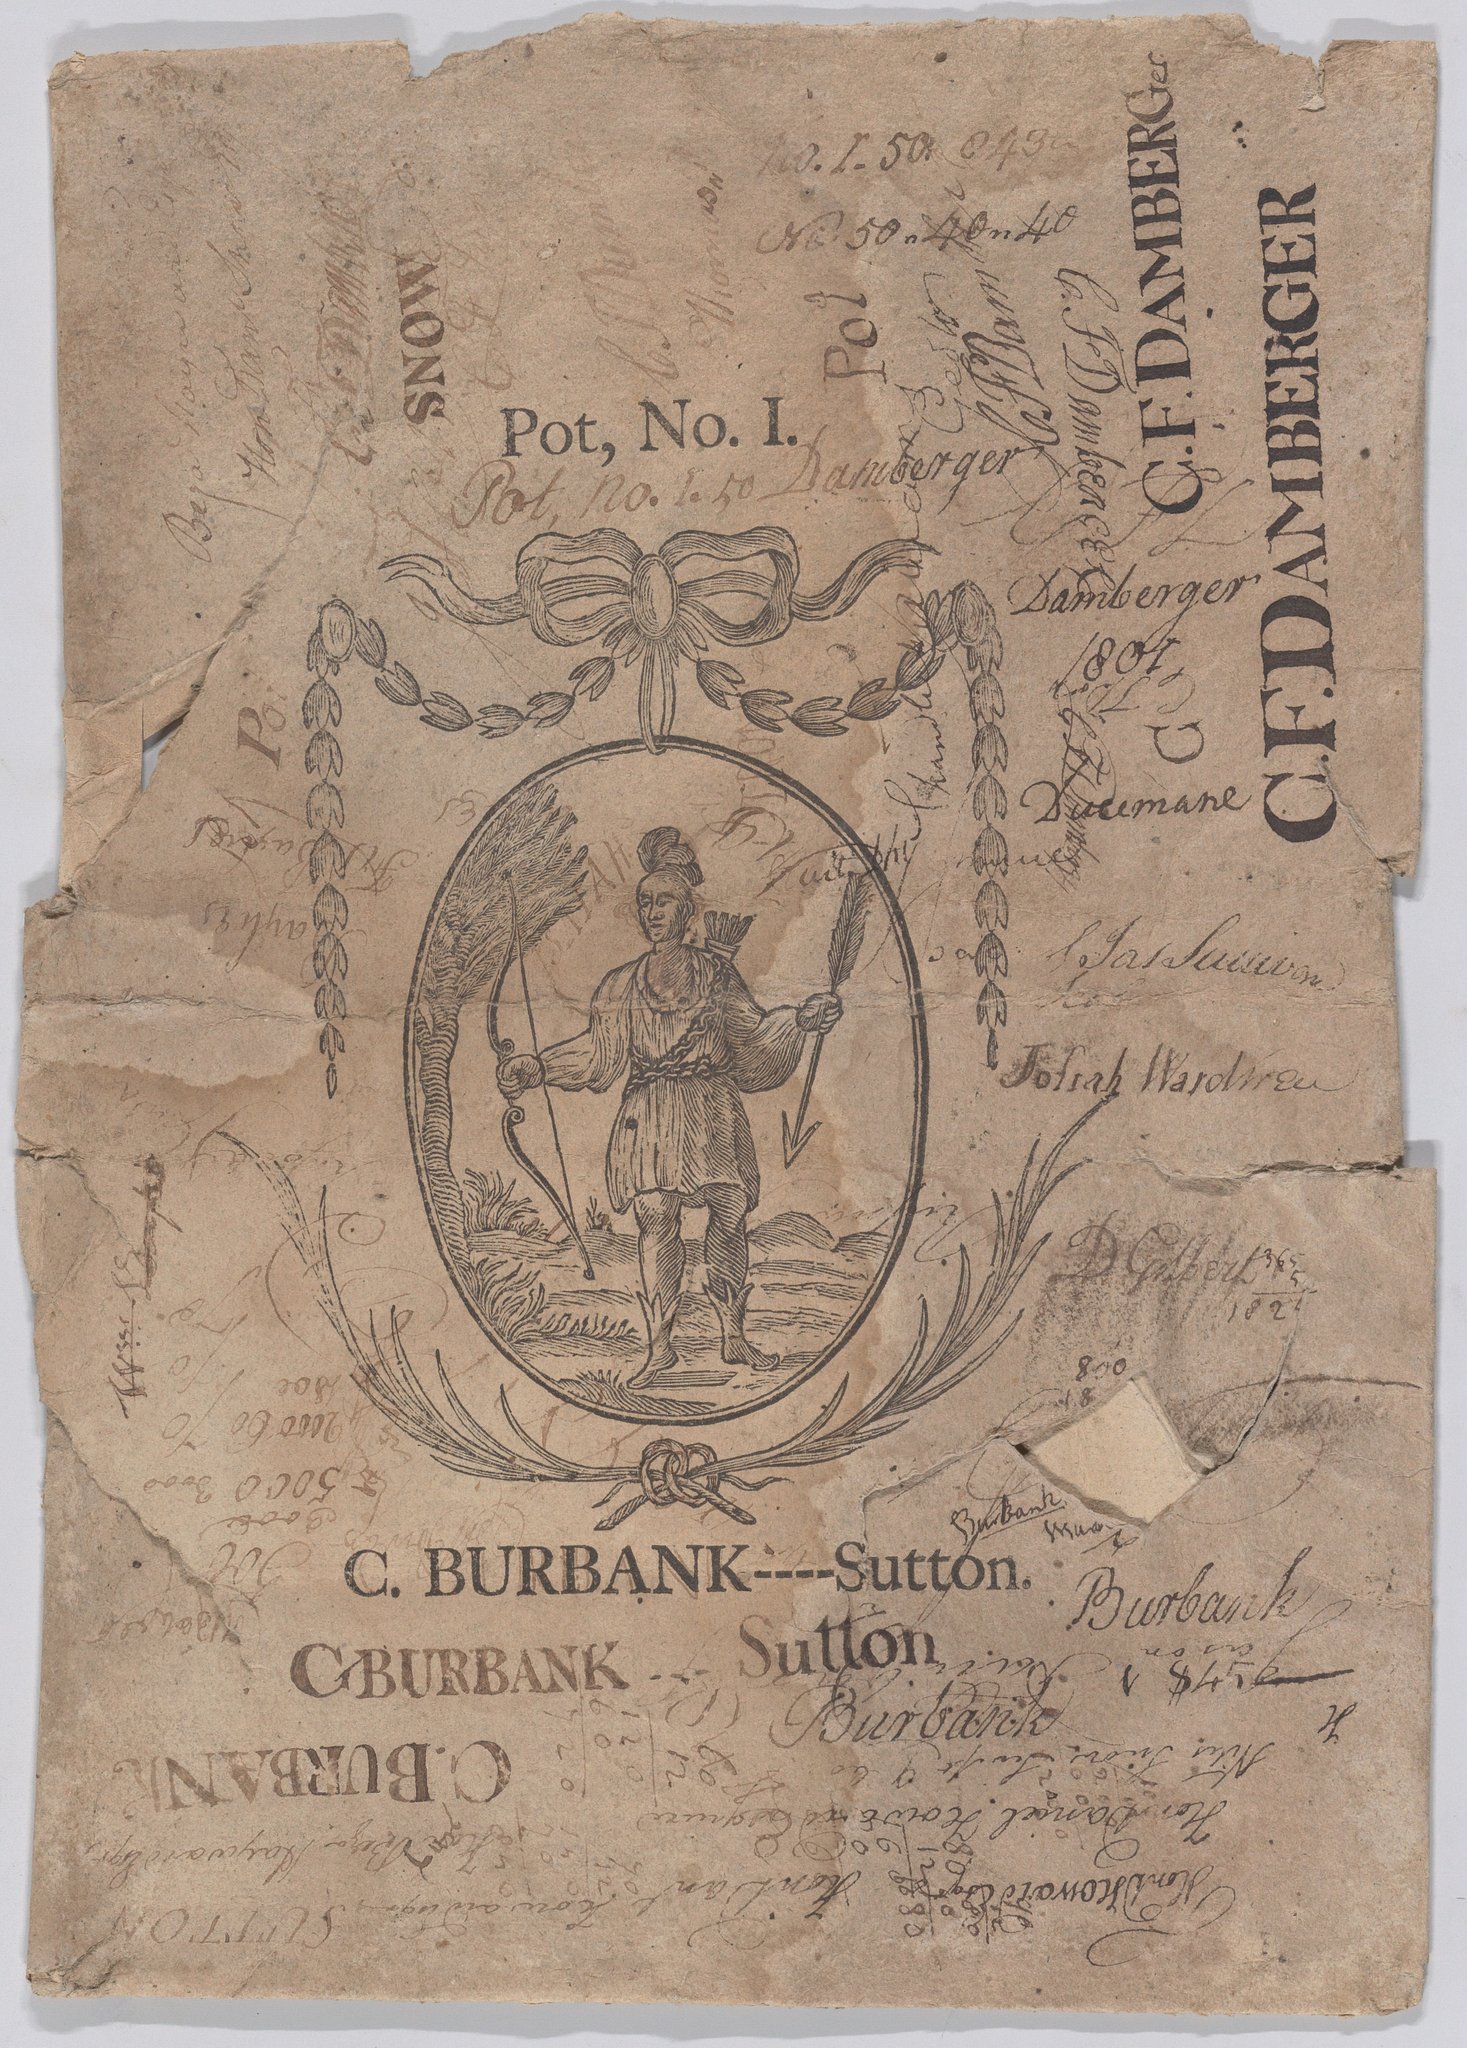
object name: print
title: Wrapper: Burbank Paper Mill, Sutton, Massachusetts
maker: caleb burbank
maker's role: manufacturer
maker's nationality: american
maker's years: 1761-1861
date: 1801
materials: ink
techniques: pen, stamping, woodcut